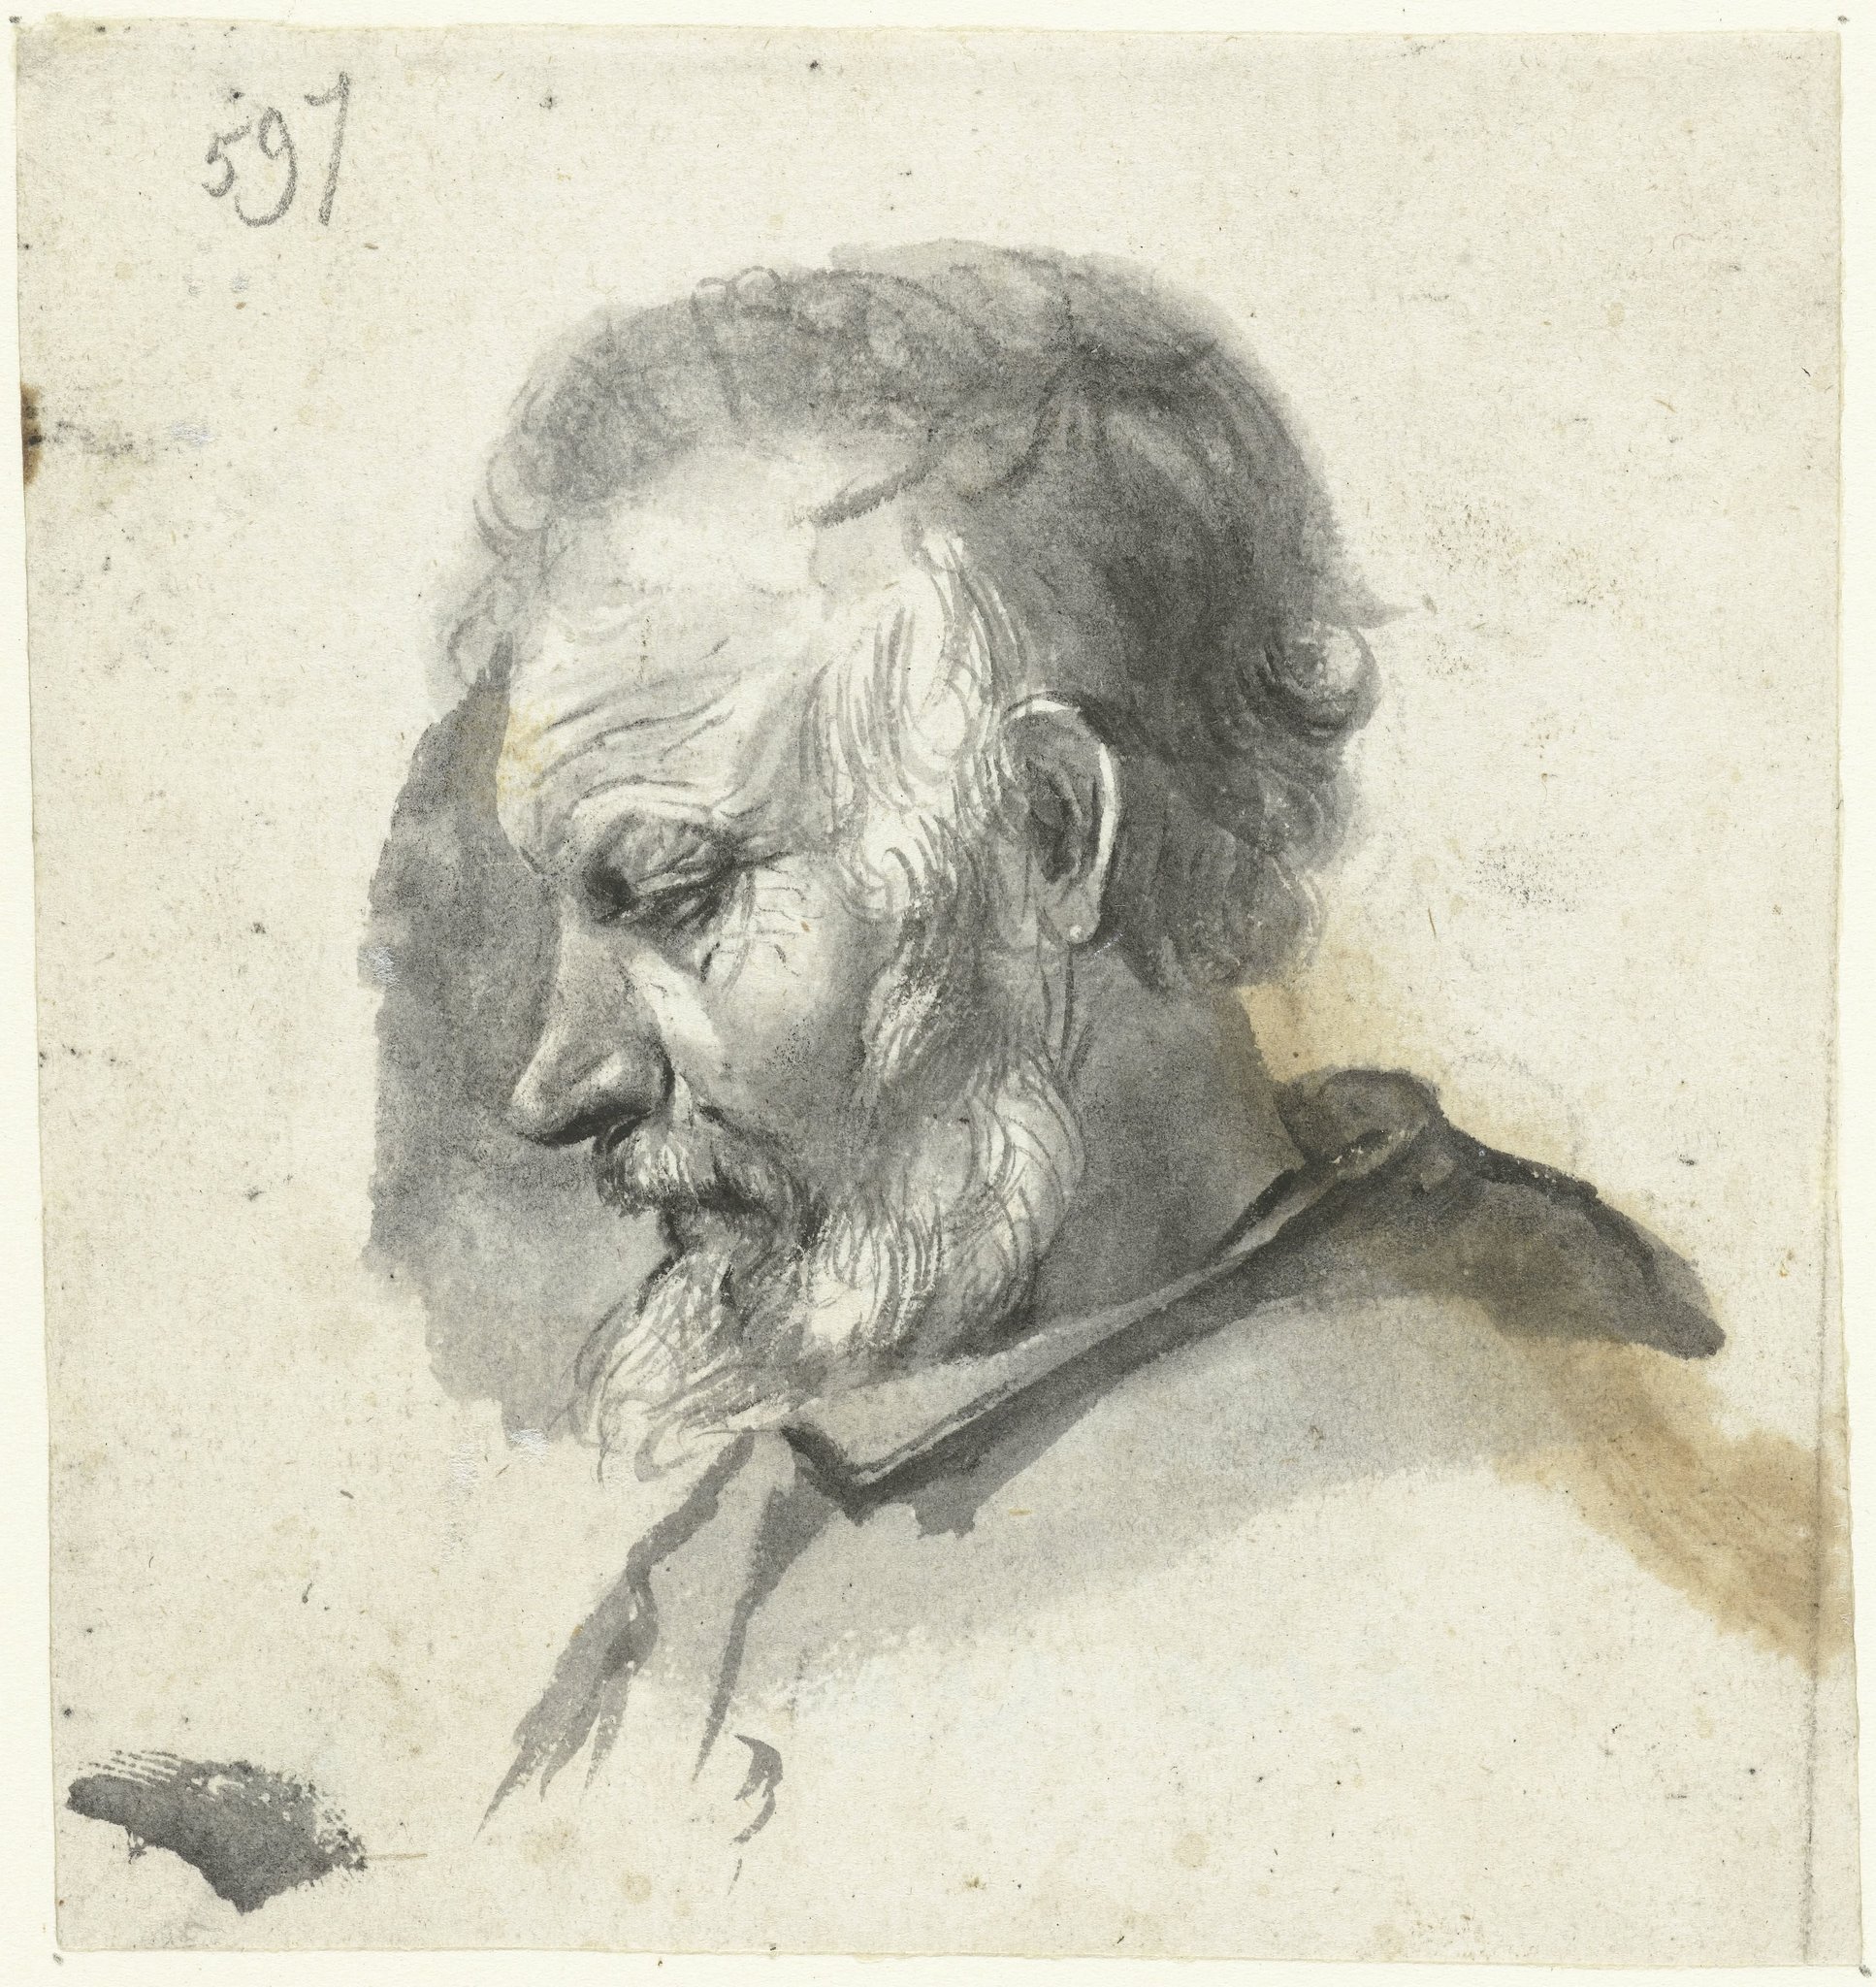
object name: drawing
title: Hoofd van een oude man, in profiel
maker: moses ter borch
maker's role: draughtsman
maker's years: 1645-1667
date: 1660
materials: chalk, paper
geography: zwolle